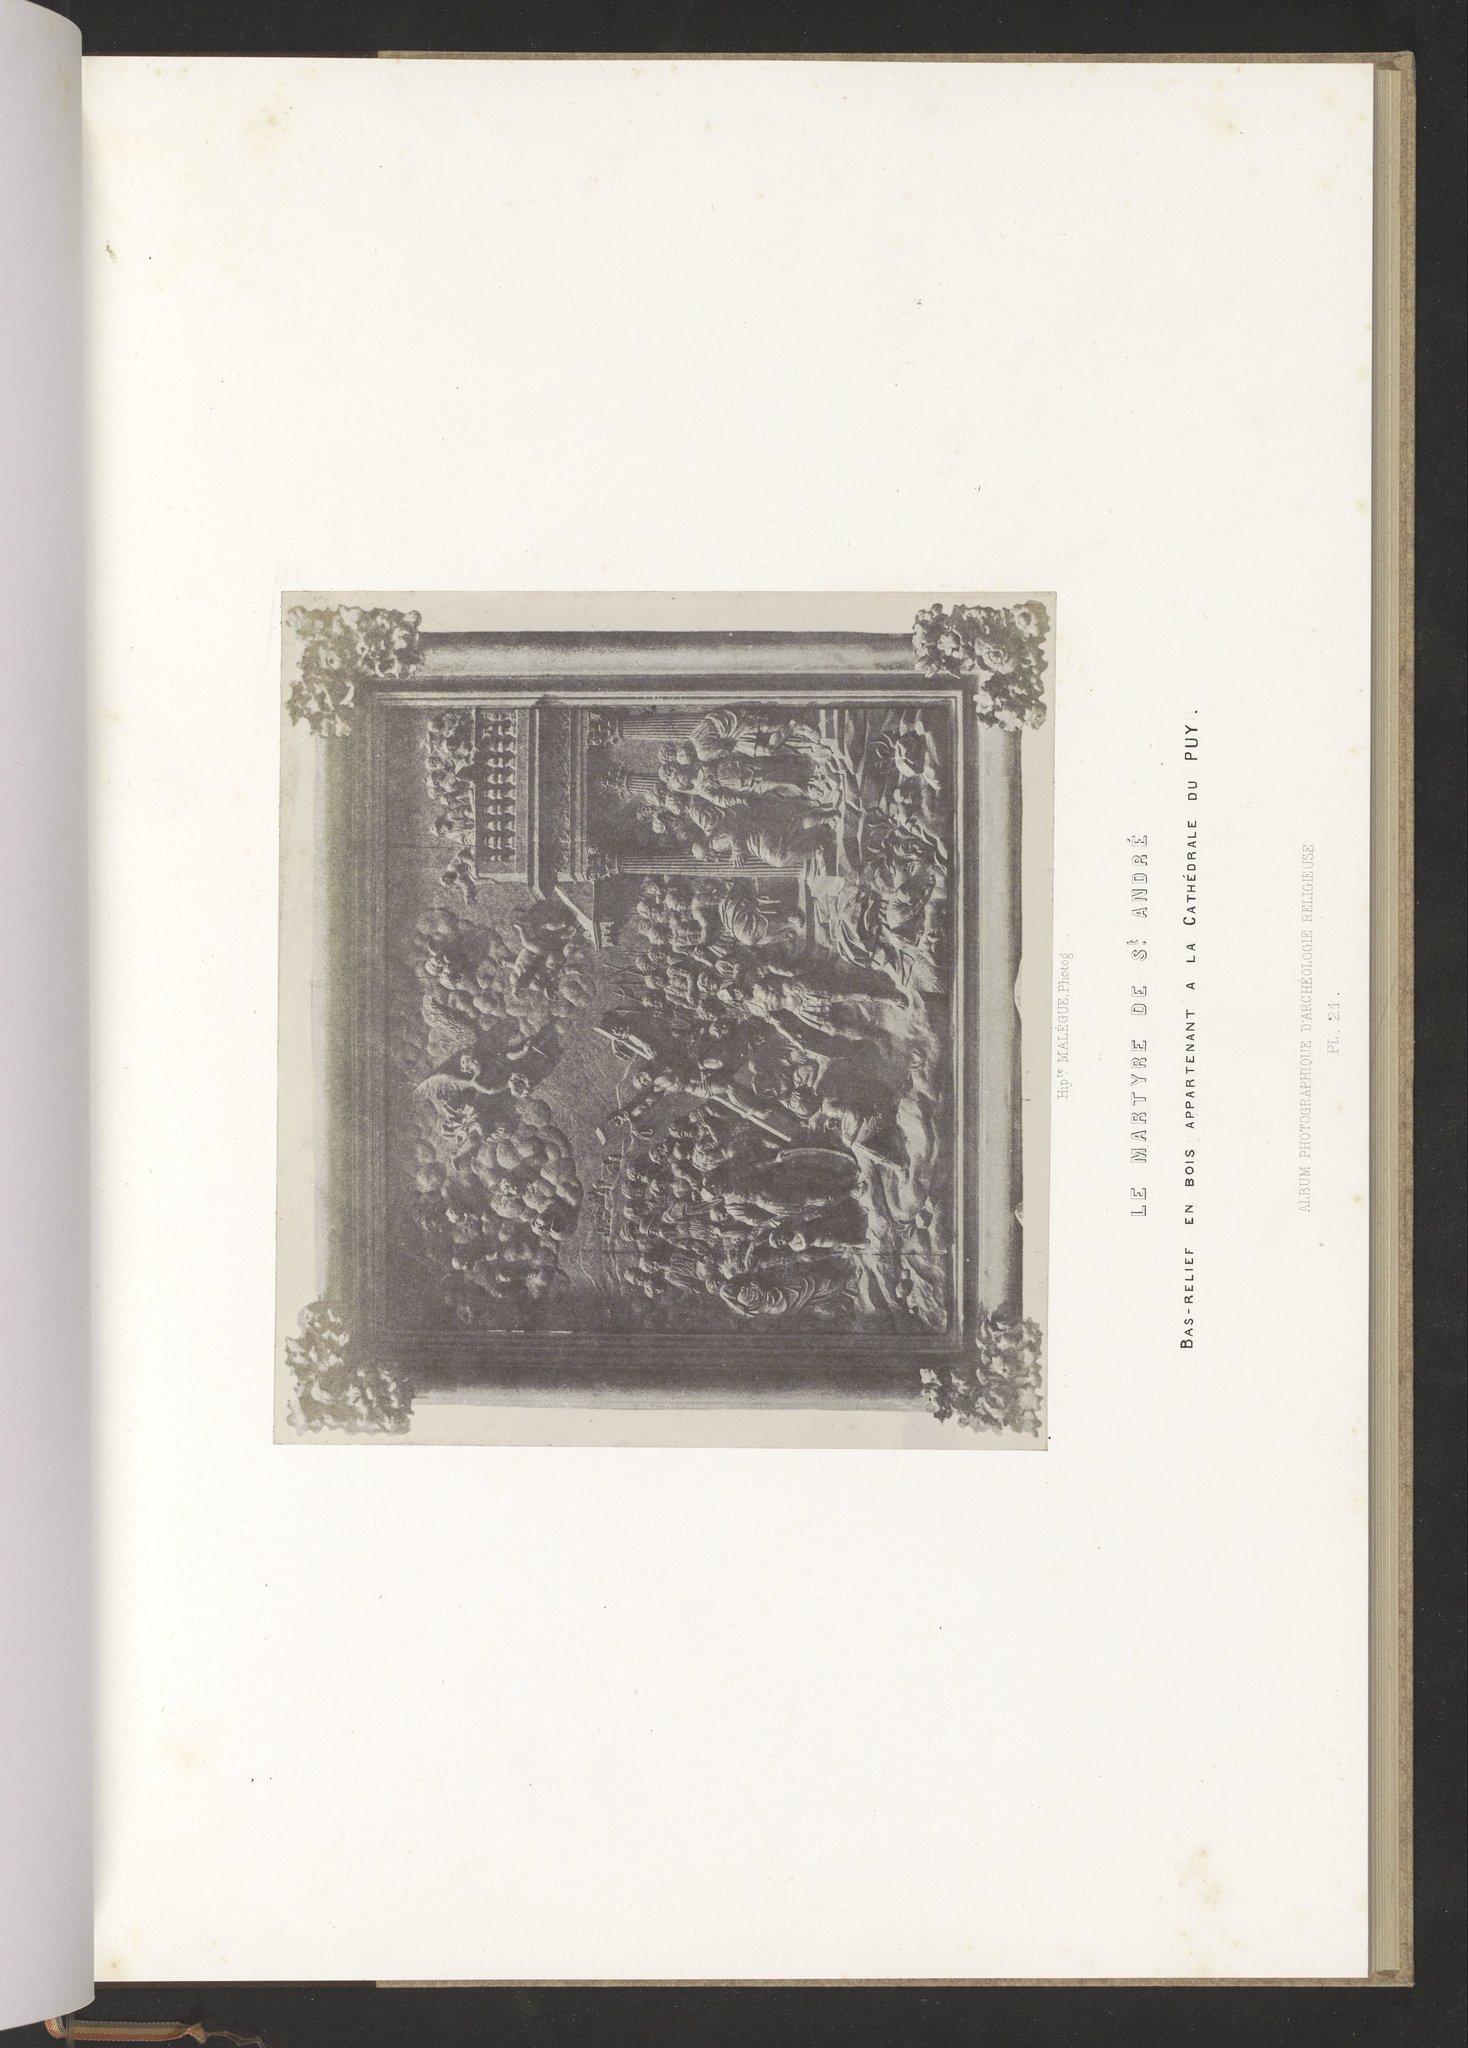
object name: page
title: Le martyre de St. André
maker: hippolyte malègue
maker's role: archeoloog, fotograaf, schrijver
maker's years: 1825-1901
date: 1850-1857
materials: photographic support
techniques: salted paper print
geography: france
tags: crucifixion of andrew: he is undressed and tied to the cross, sculpture (+ relief ~ sculpture)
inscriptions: inscription: ‘Bas-relief en bois appartenant a la Cathédrale du Puy.’, number: ‘PL. 21.’